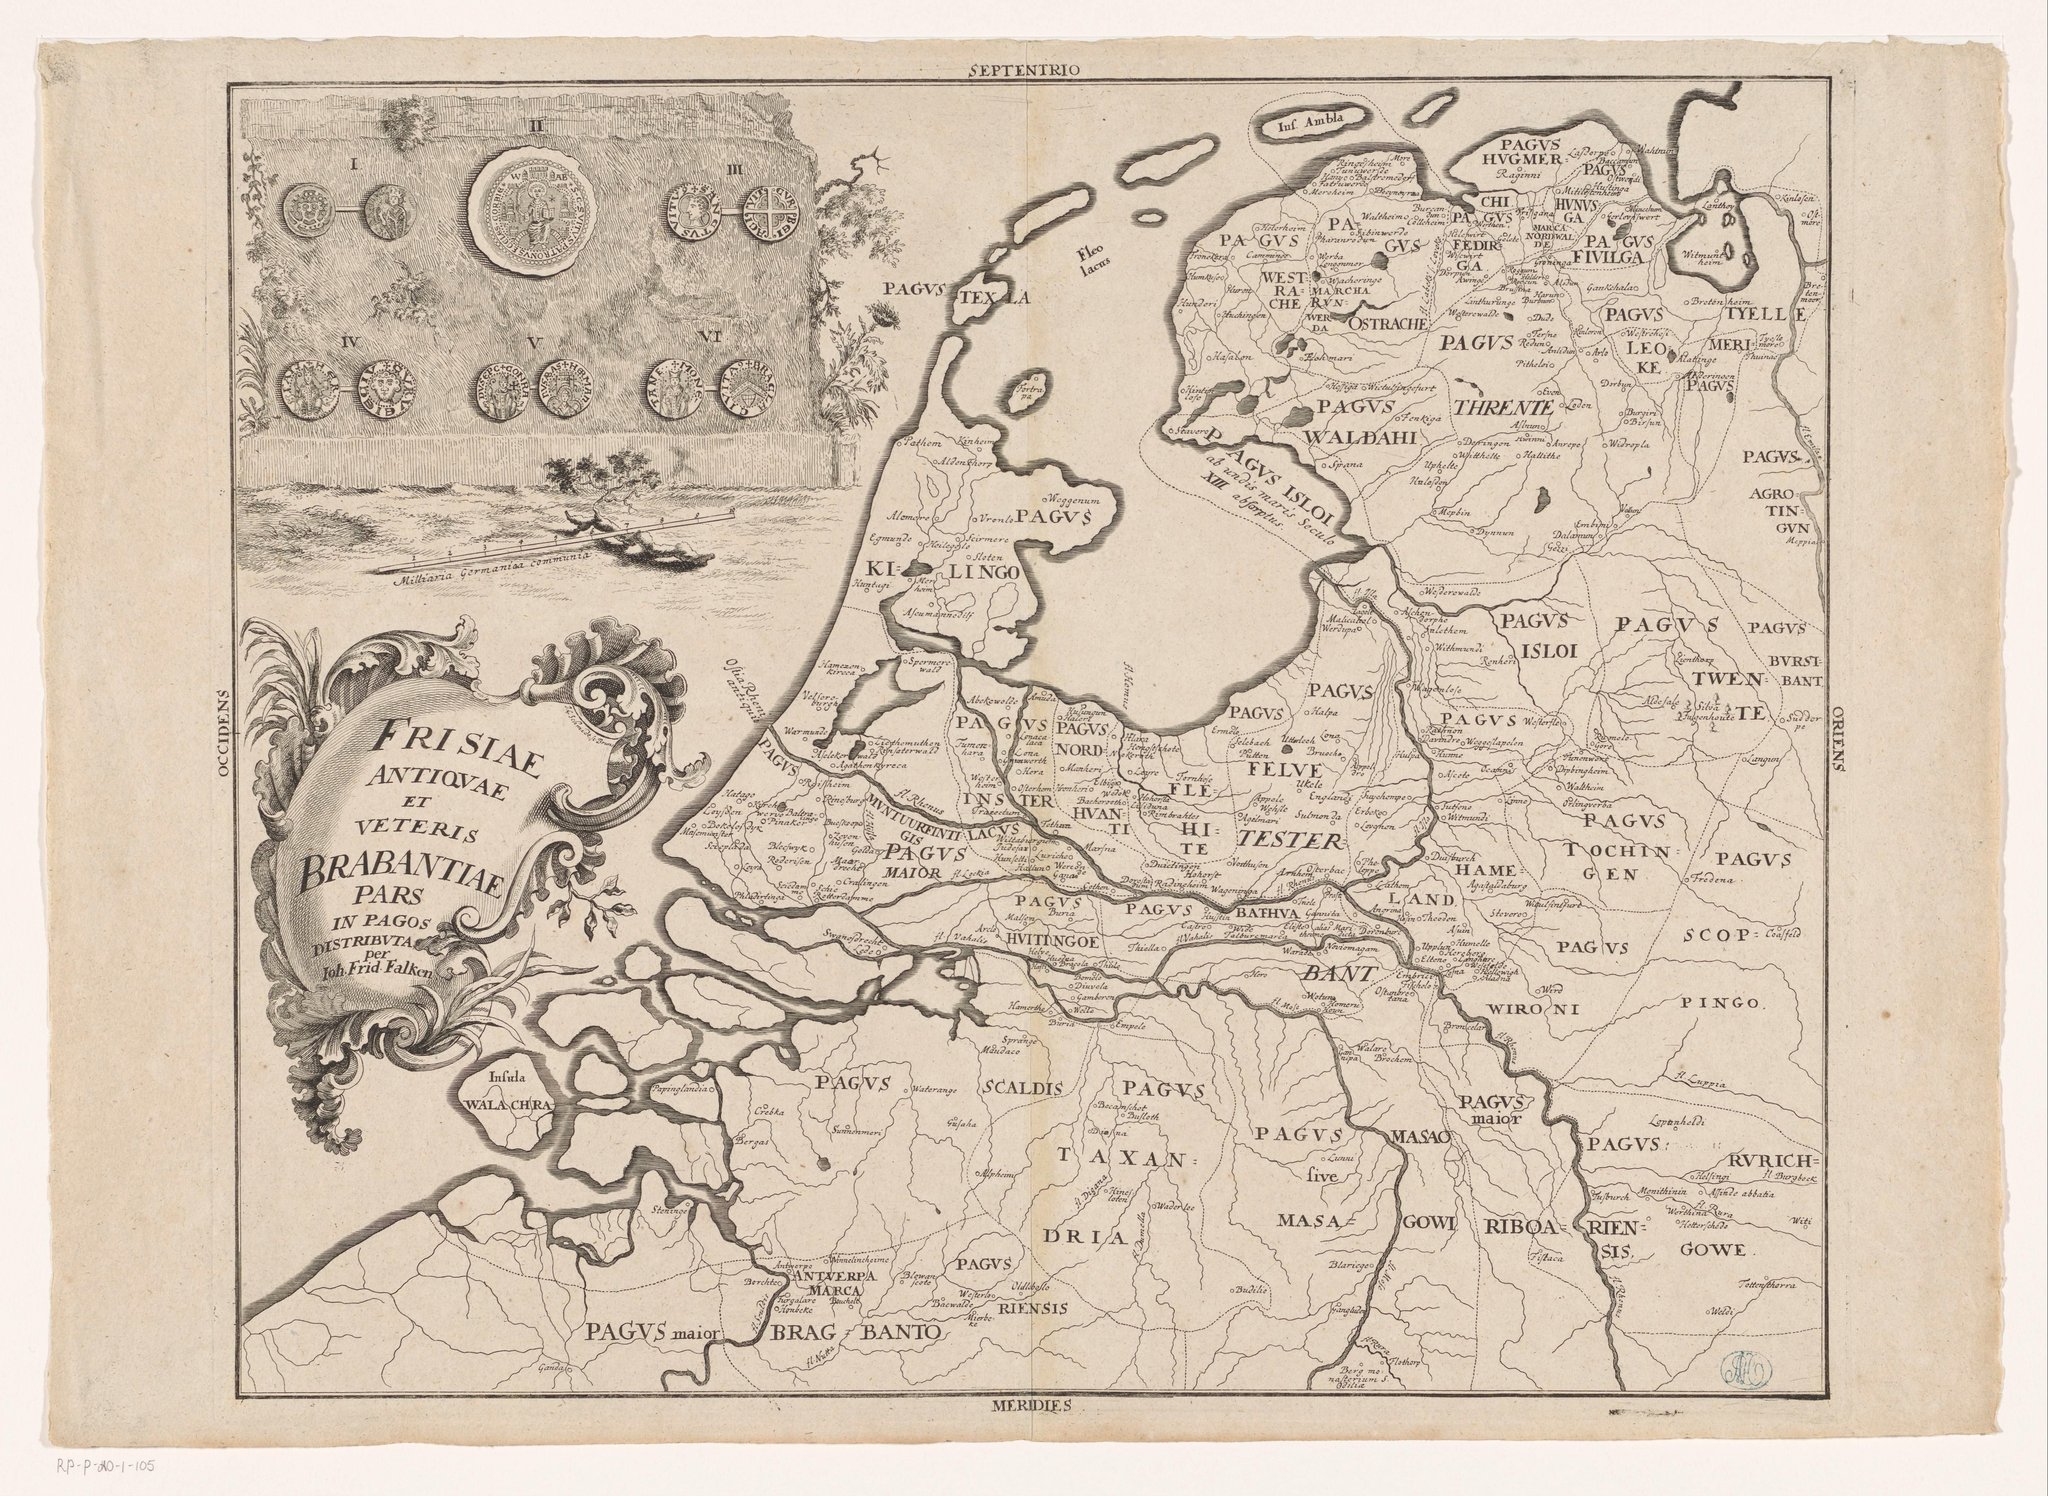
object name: map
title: Historische kaart van Nederland in de laat-Romeinse tijd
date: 1730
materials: paper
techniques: engraving, etching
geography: braunschweig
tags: maps of separate countries or regions, coin, netherlands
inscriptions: collector's mark: Lugt 195, collector's mark: Lugt 2228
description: Historische kaart van Nederland in de laat-Romeinse tijd, verdeeld in gouwen ('pagi'). Linksboven een muur met daarop verschillende laat-Romeinse en vroegchristelijke of Frankische munten. Daaronder schaalstok: Milliaria Germanica communia. Daaronder titelcartouche.